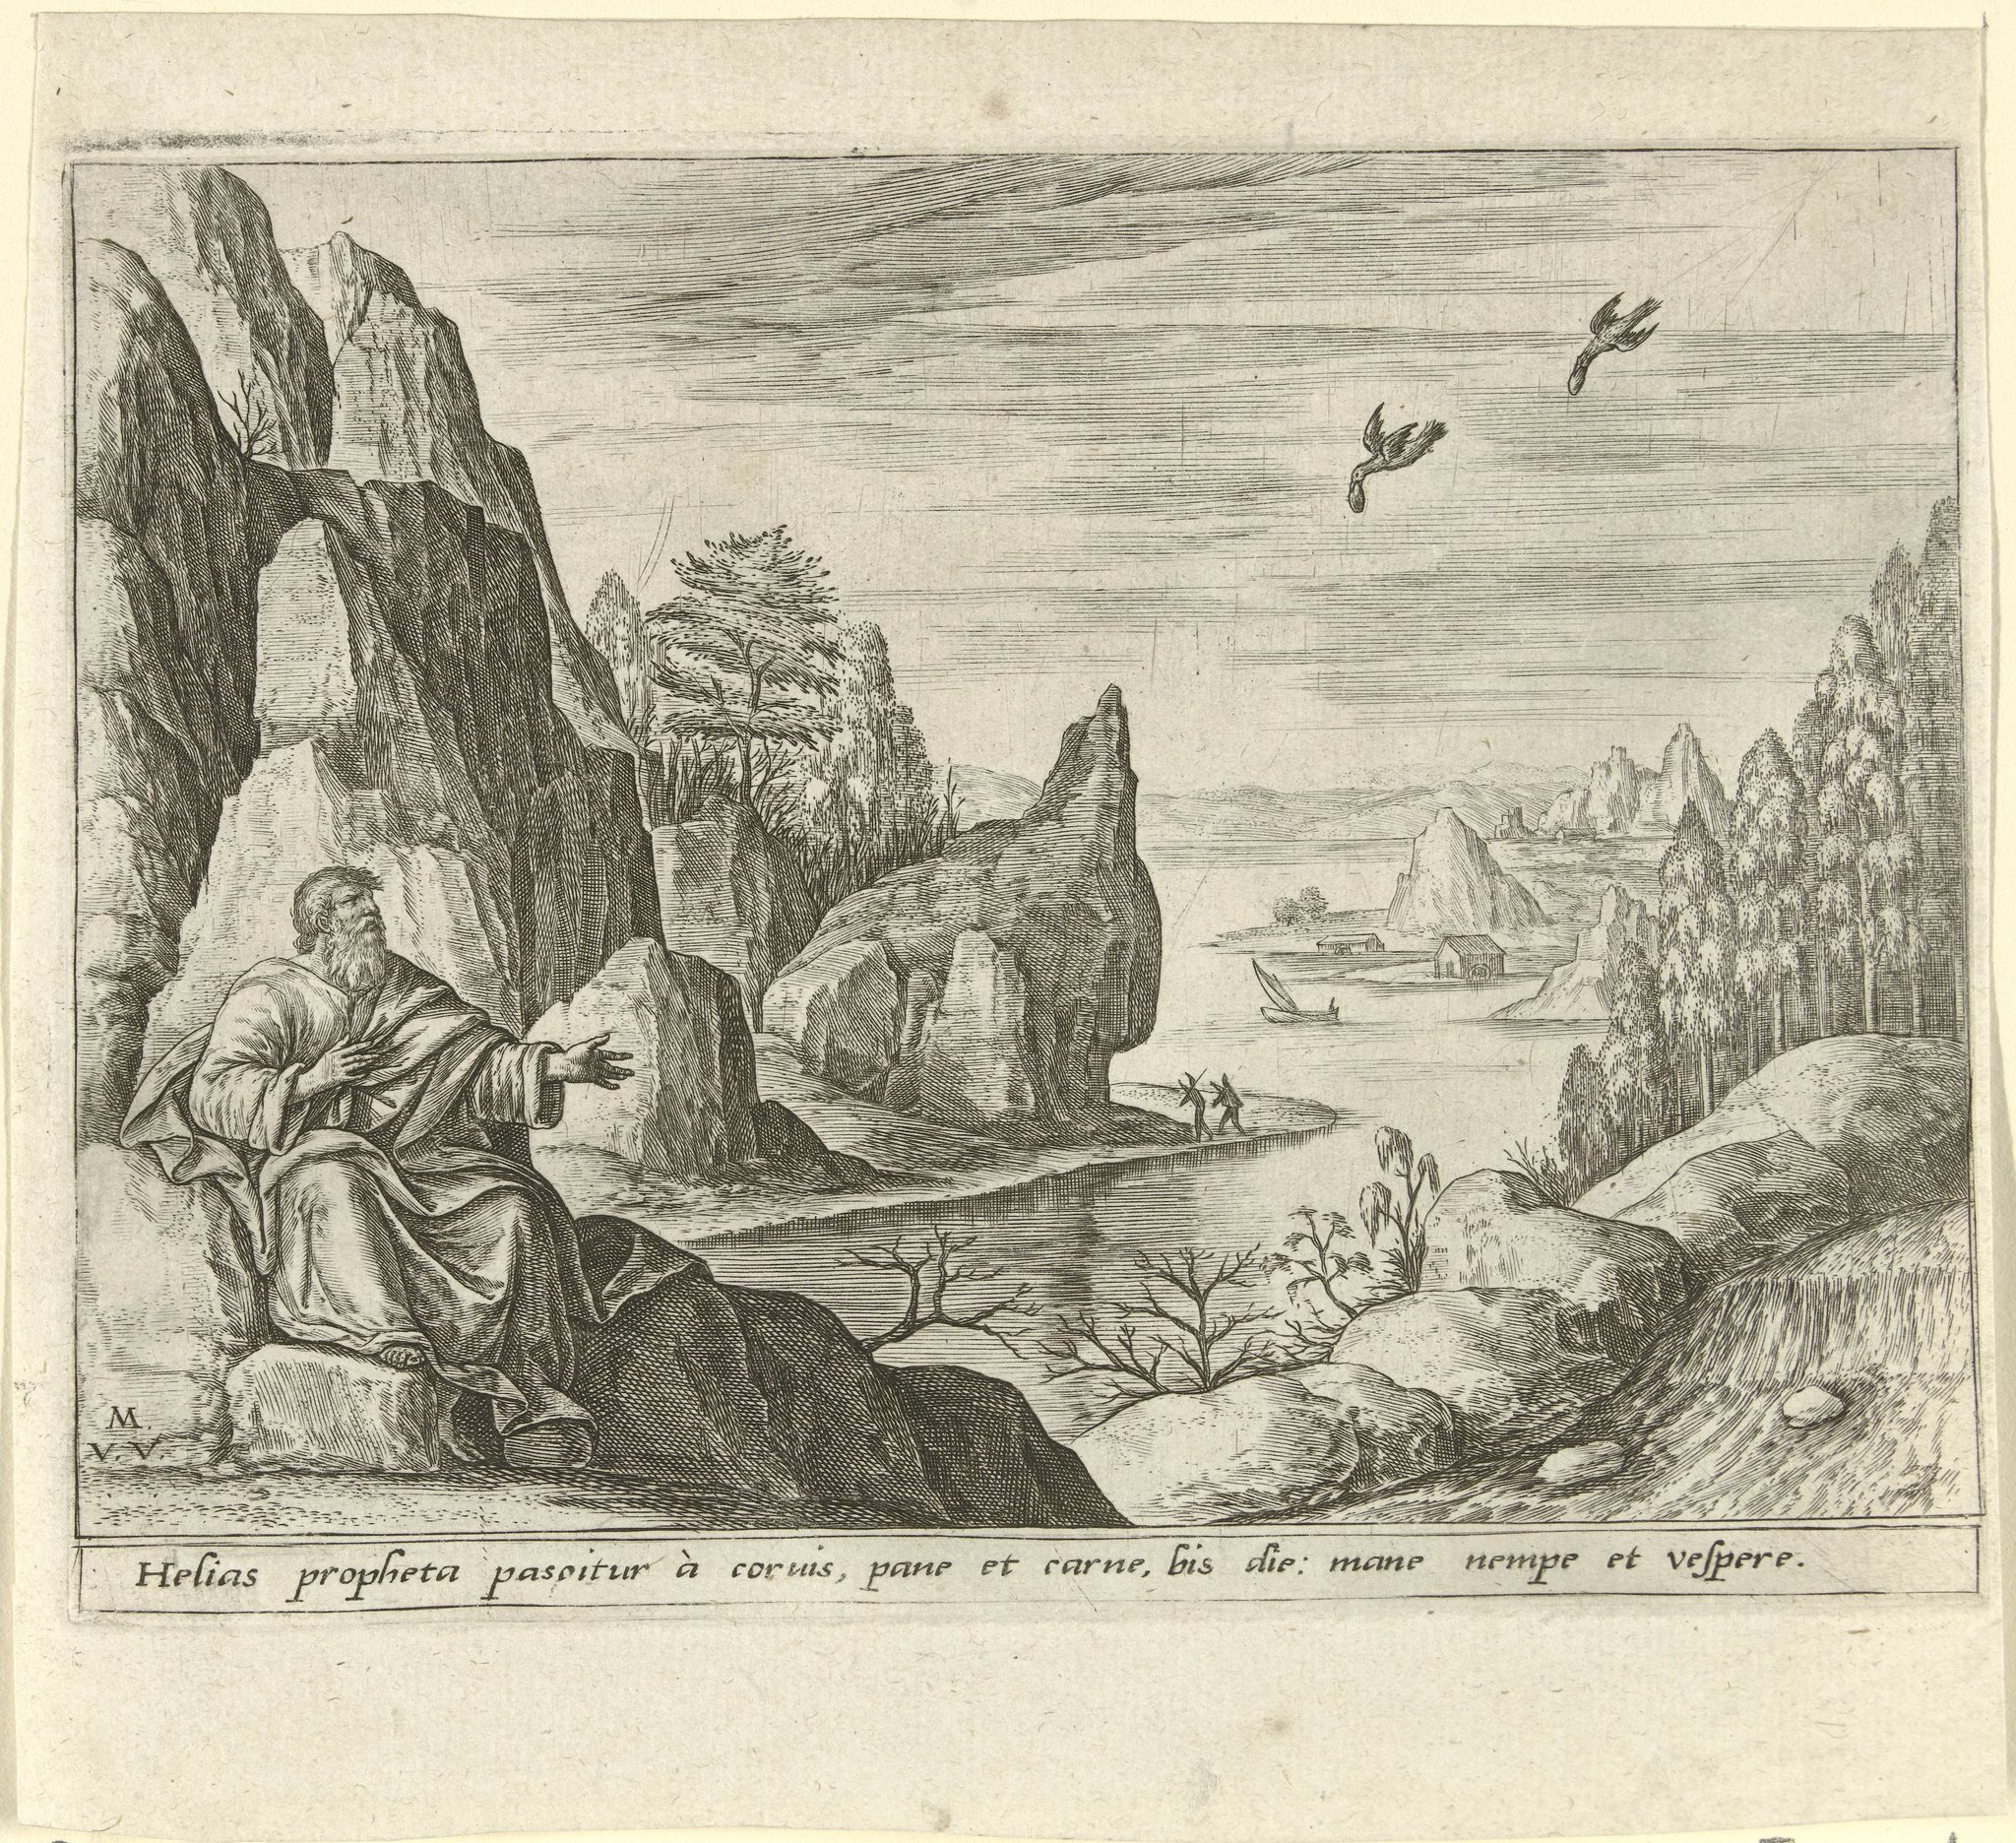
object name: print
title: Elia gevoed door raven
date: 1625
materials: paper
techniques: engraving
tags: elijah fed by the raven(s): while the prophet is living by the brook, ravens bring him food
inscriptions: collector's mark: Lugt 2228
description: Bergachtig landschap met Elia die op een rots langs de beek Kerit zit. Raven brengen hem brood en vlees. In de marge een onderschrift in het Latijn.